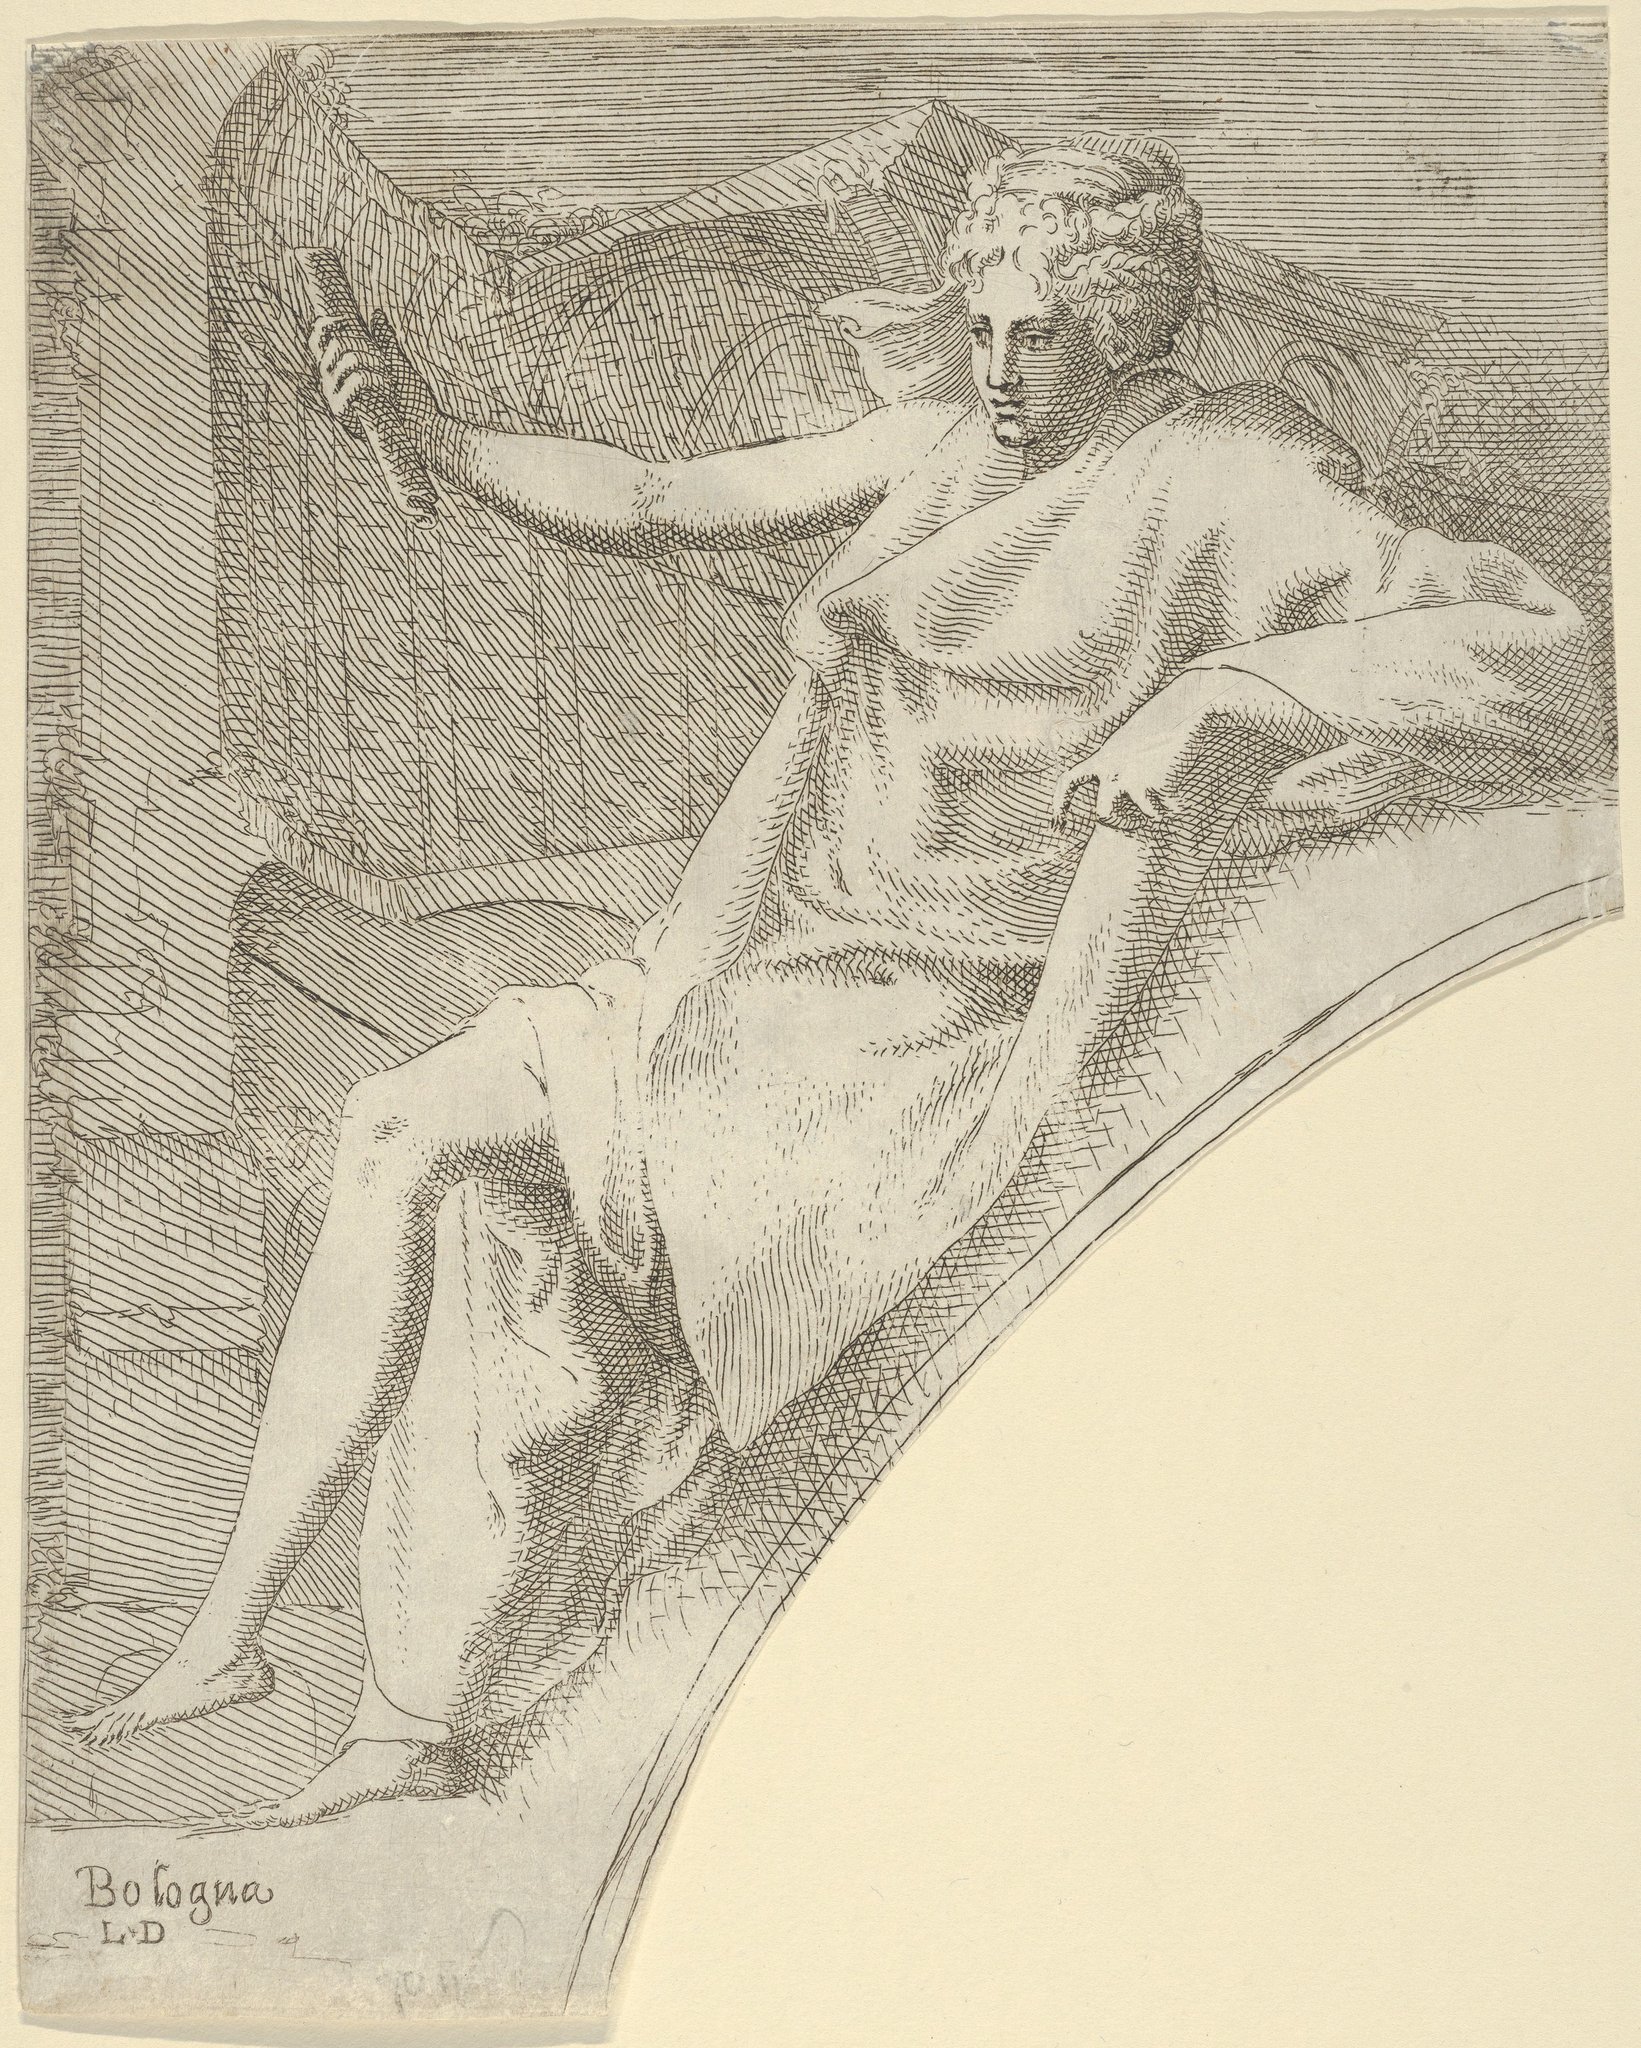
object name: print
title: Thalia, from "Twelve Muses and Goddesses"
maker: léon davent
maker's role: artist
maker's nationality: french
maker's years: 1540-1556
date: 1540-1545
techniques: etching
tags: goddess